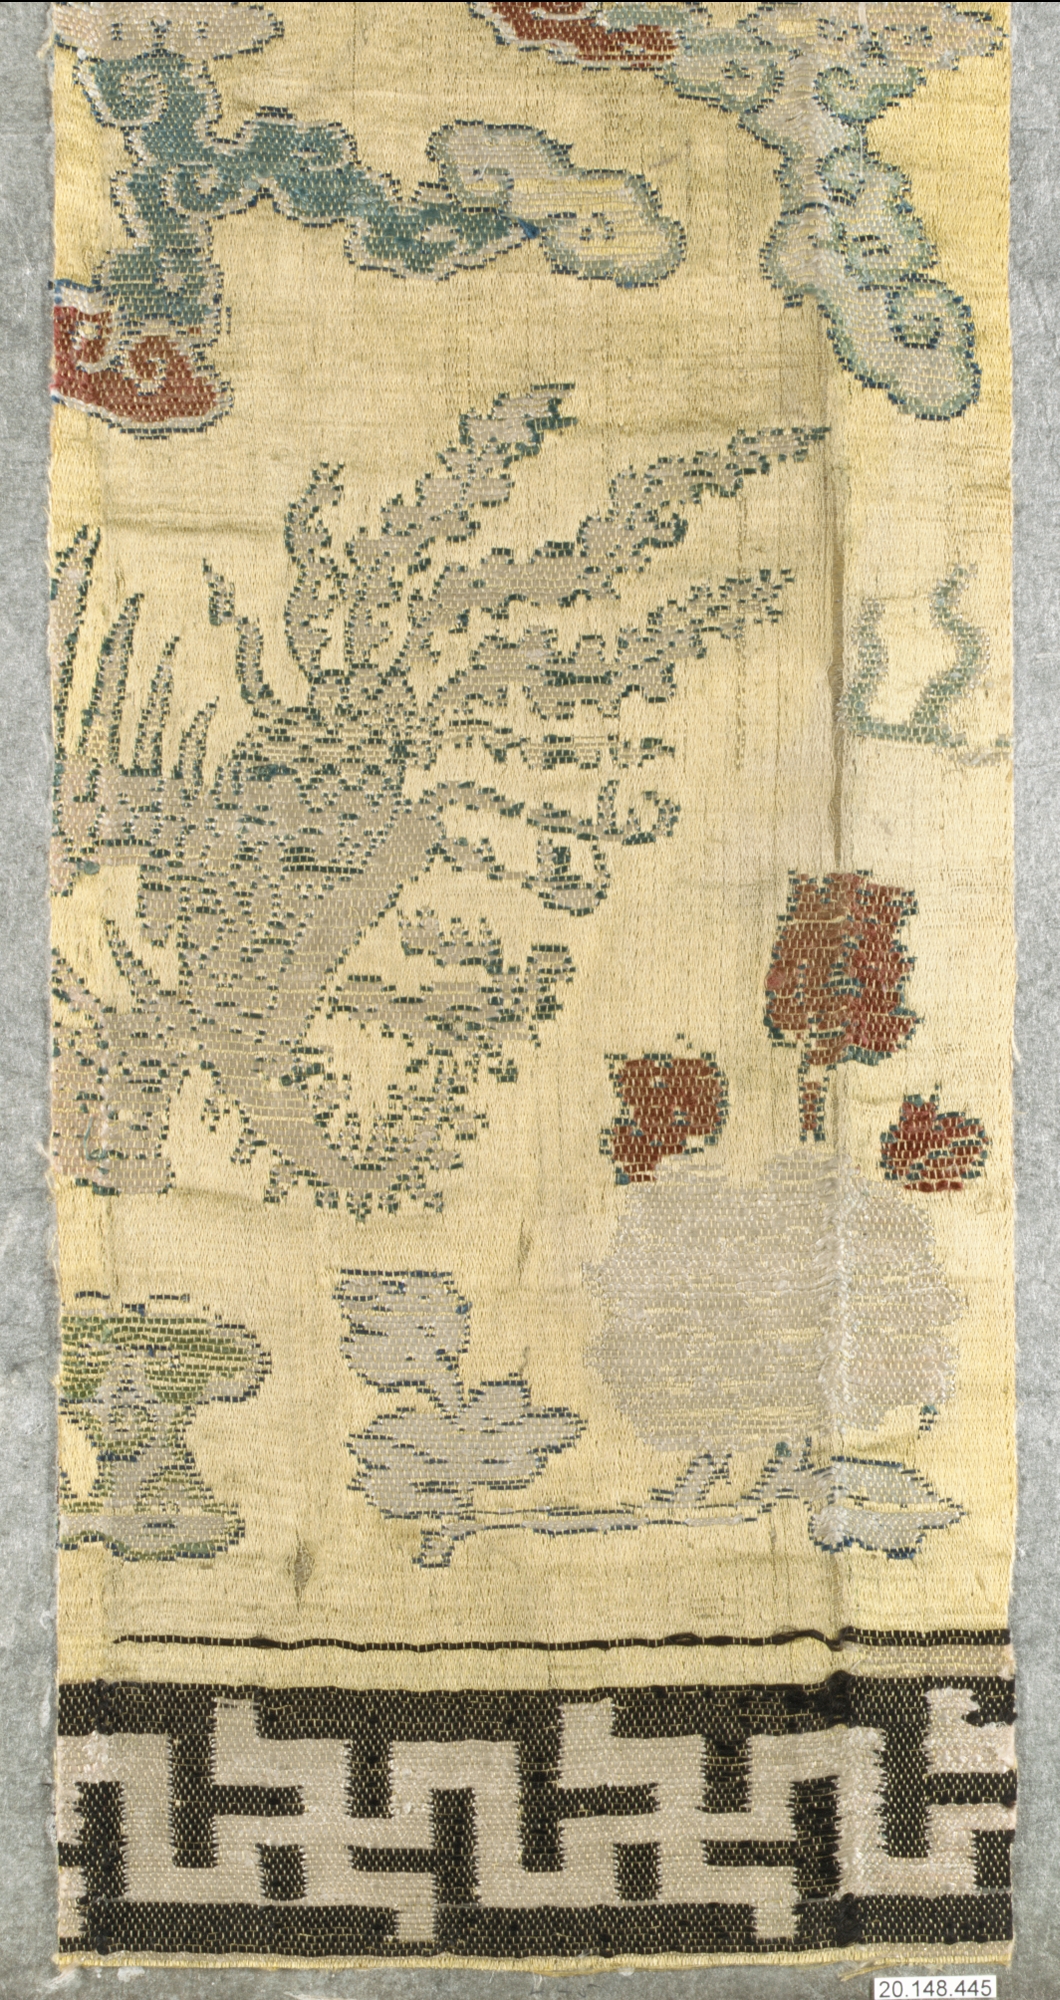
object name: piece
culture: chinese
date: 1601-1700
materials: silk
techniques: compound weave